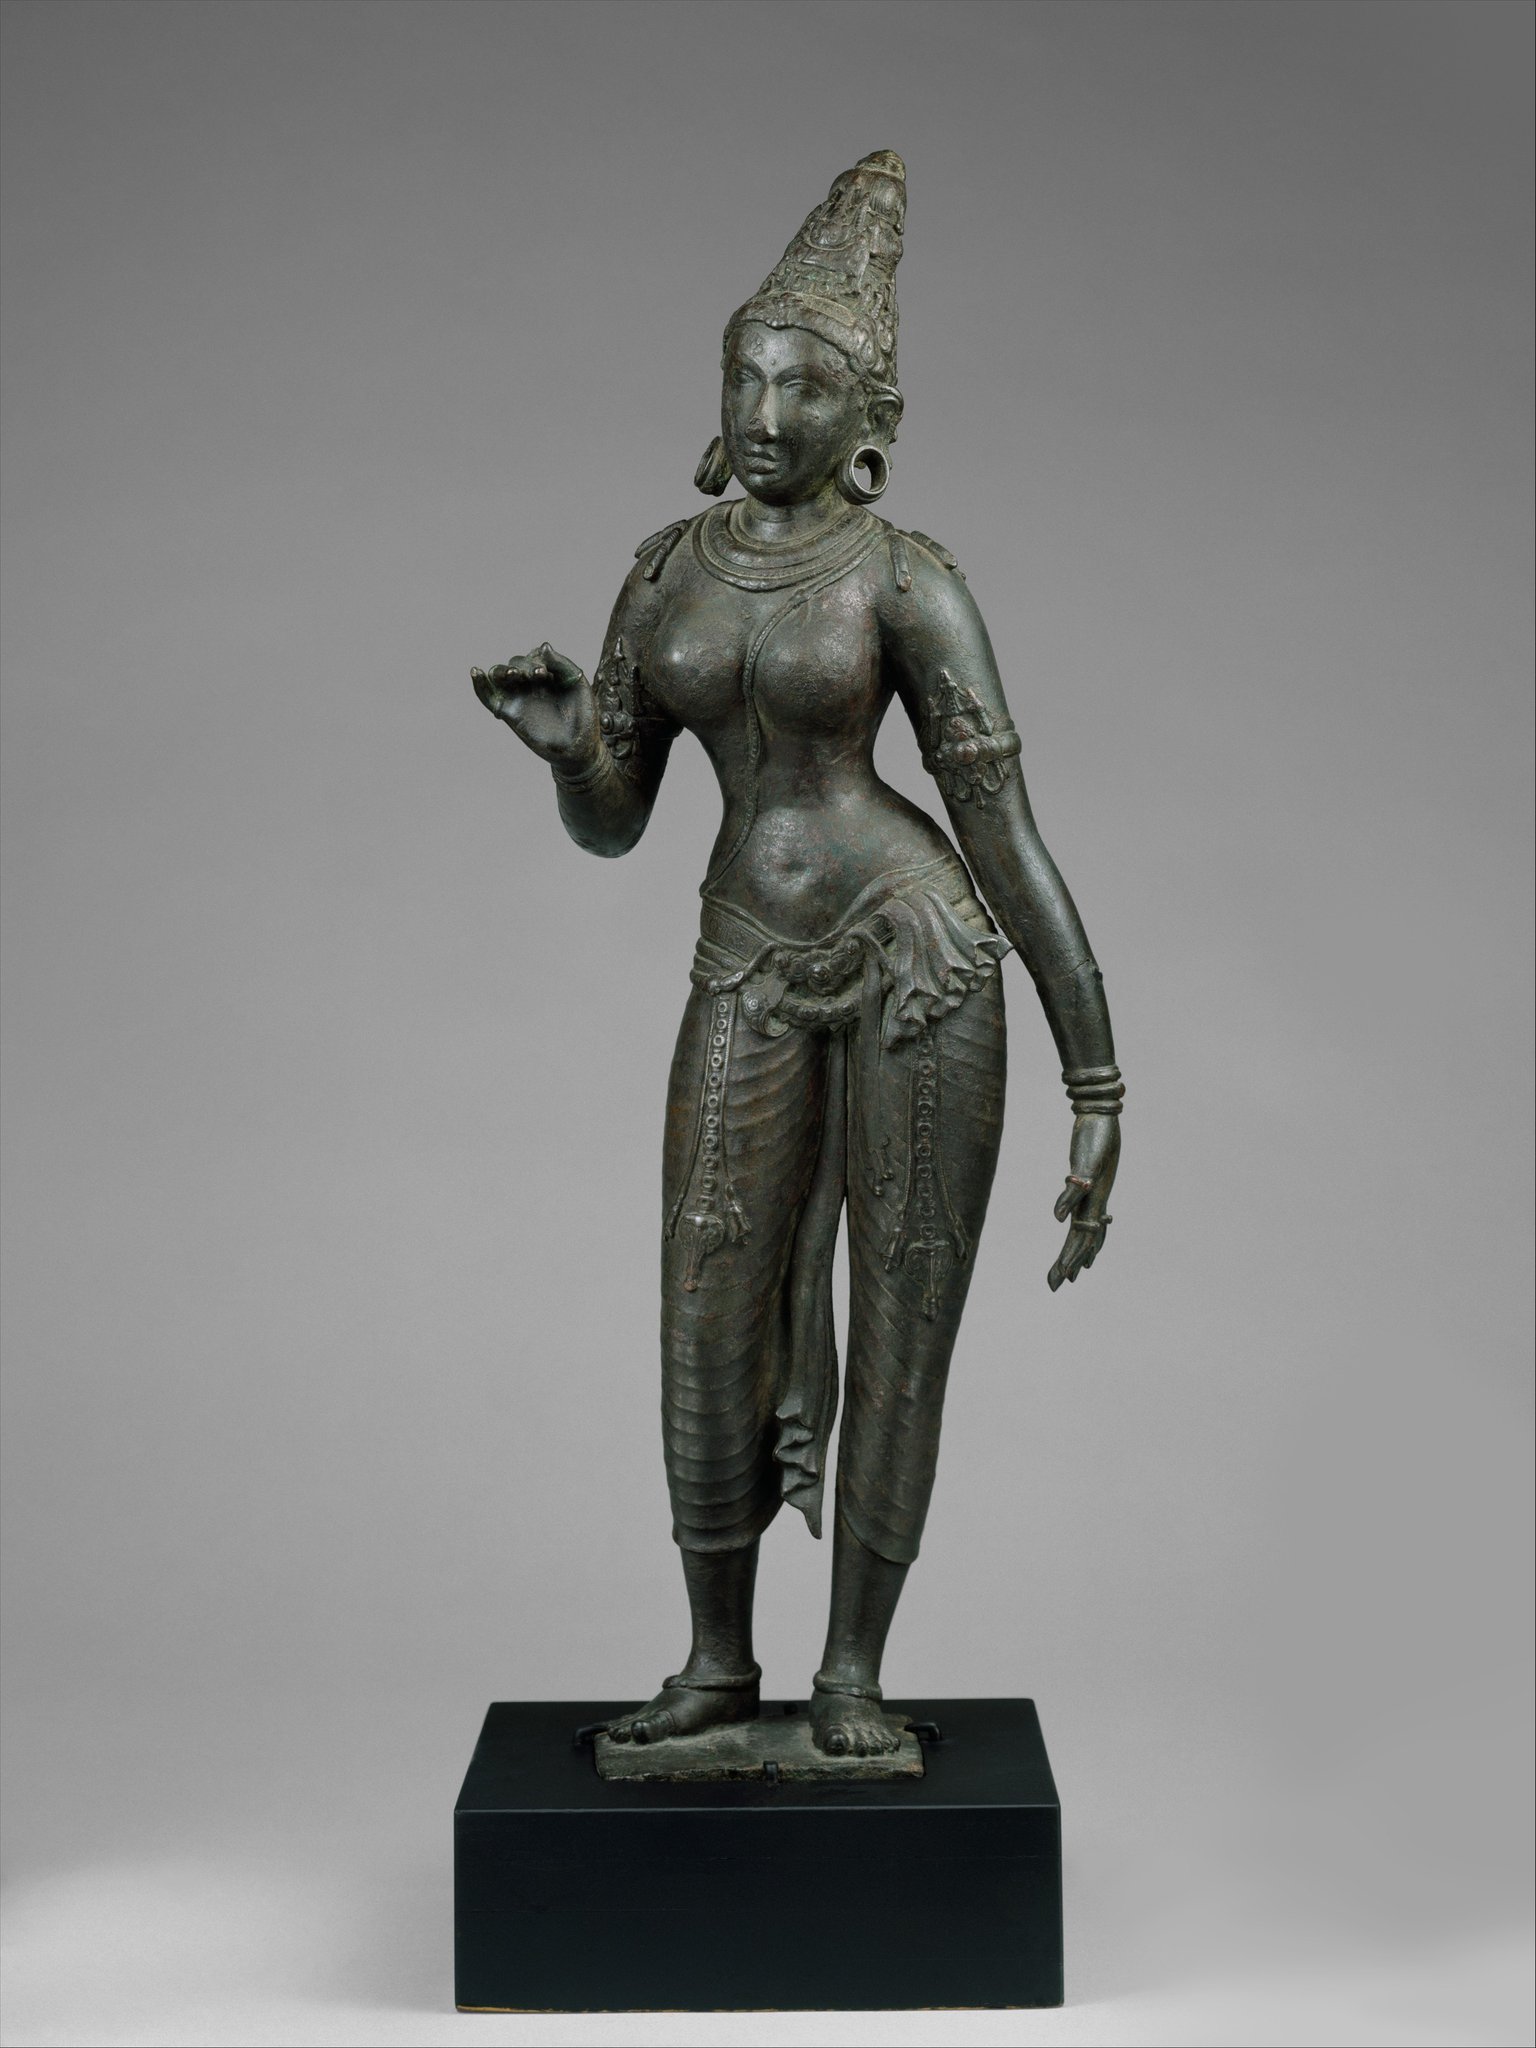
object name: figure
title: Standing Parvati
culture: indian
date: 901-925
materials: copper alloy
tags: parvati